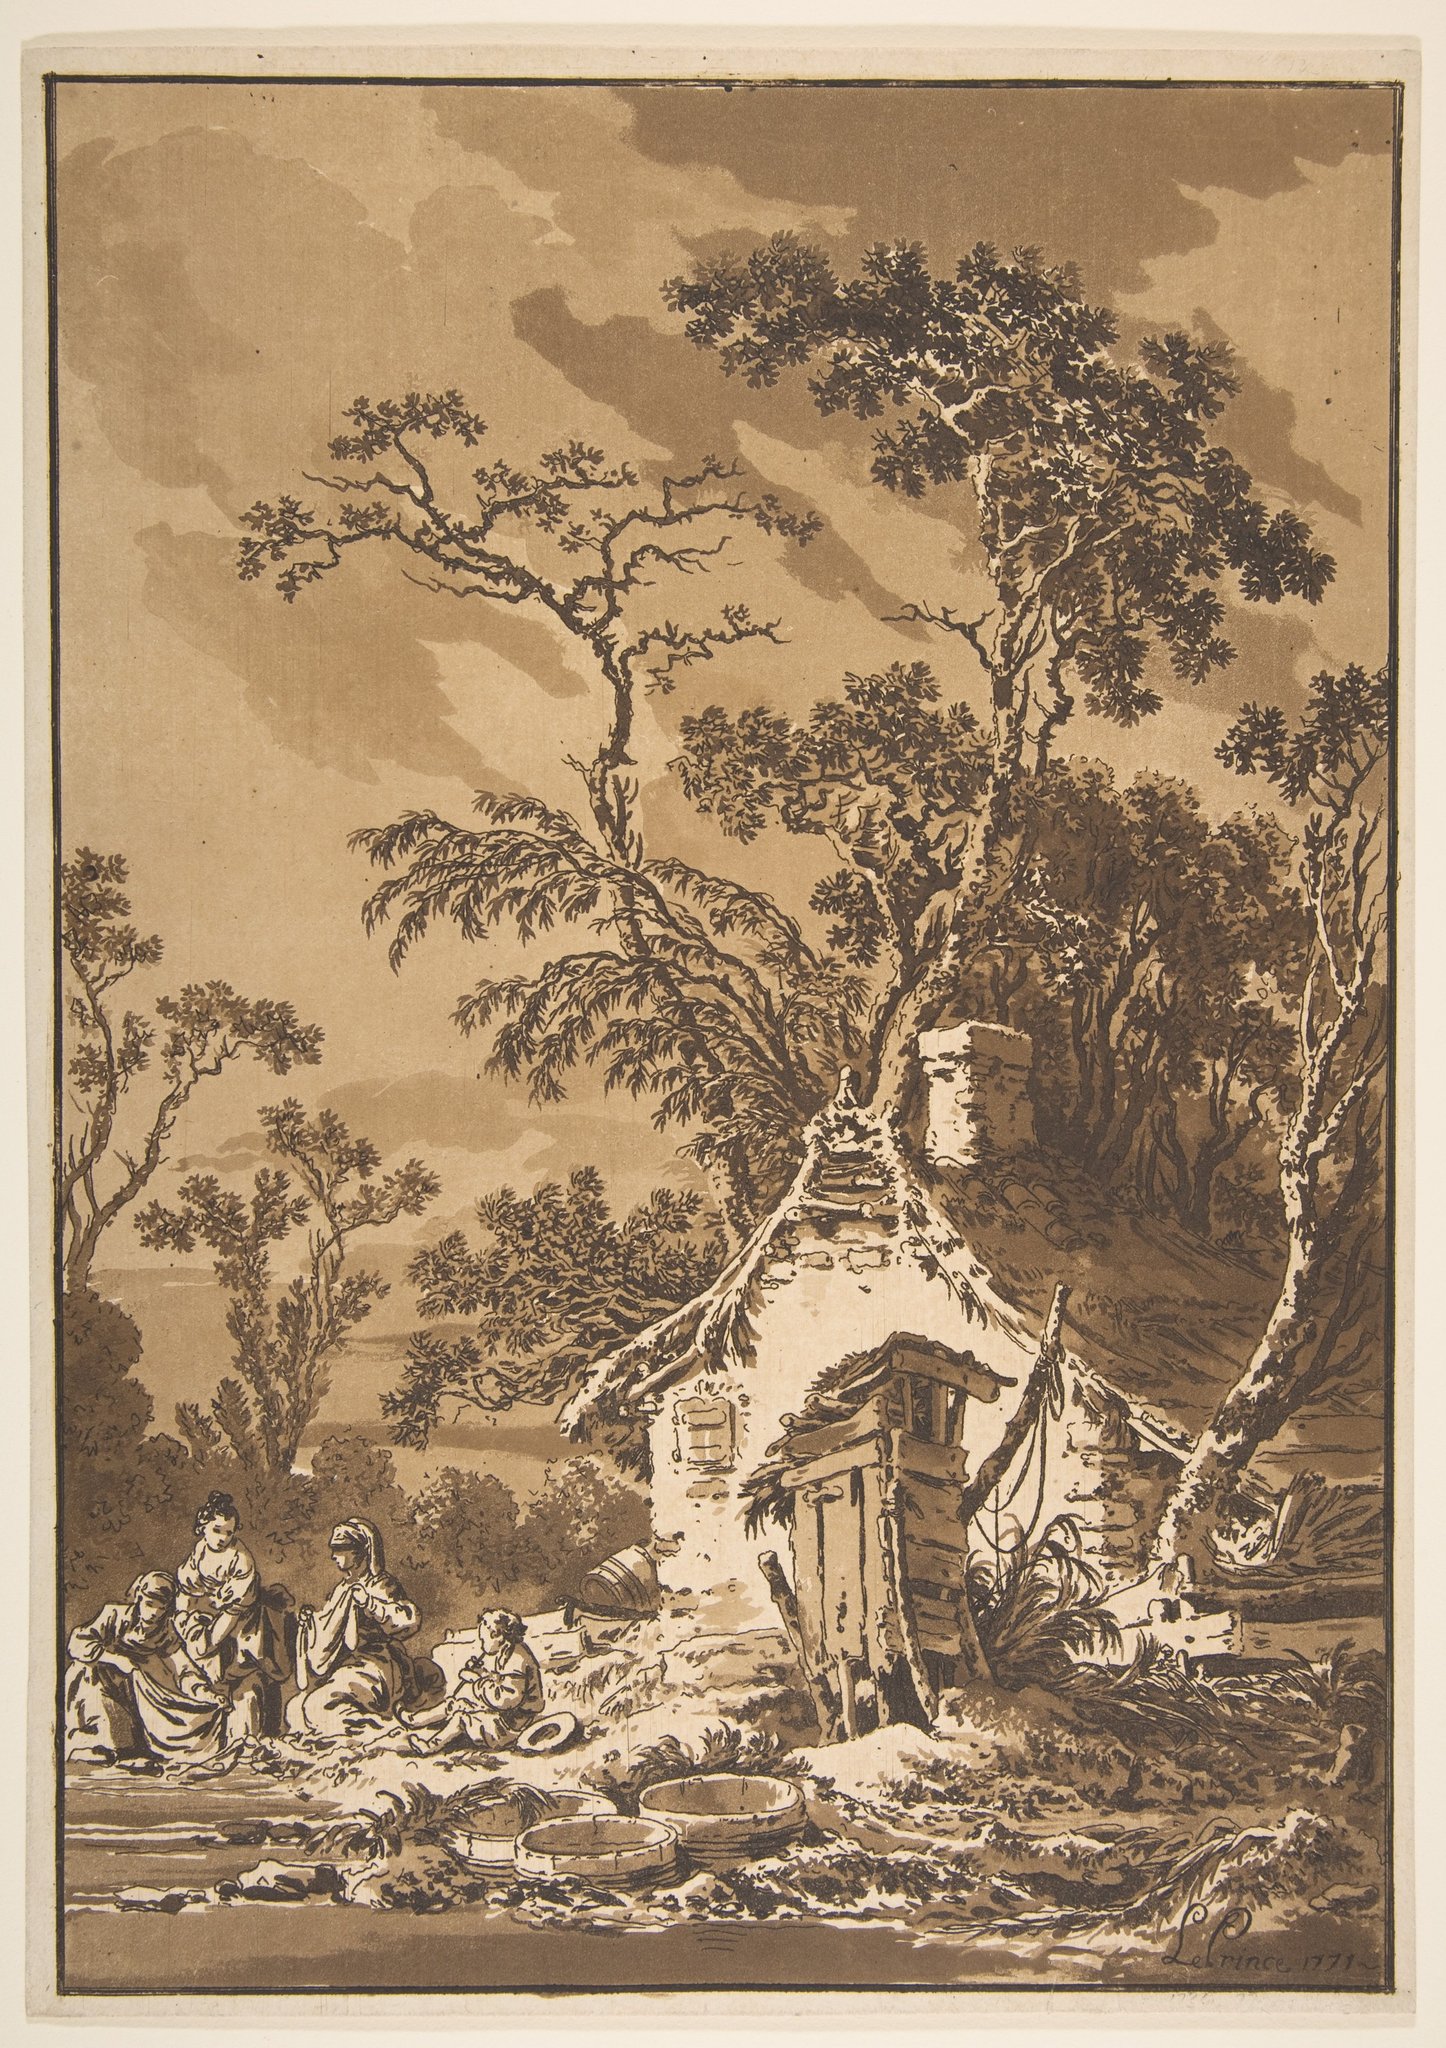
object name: print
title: The Washerwomen (Les Laveuses)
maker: jean-baptiste le prince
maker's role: artist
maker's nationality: french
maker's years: 1734-1781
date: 1771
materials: ink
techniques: aquatint, etching, printing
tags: houses,women,trees,working